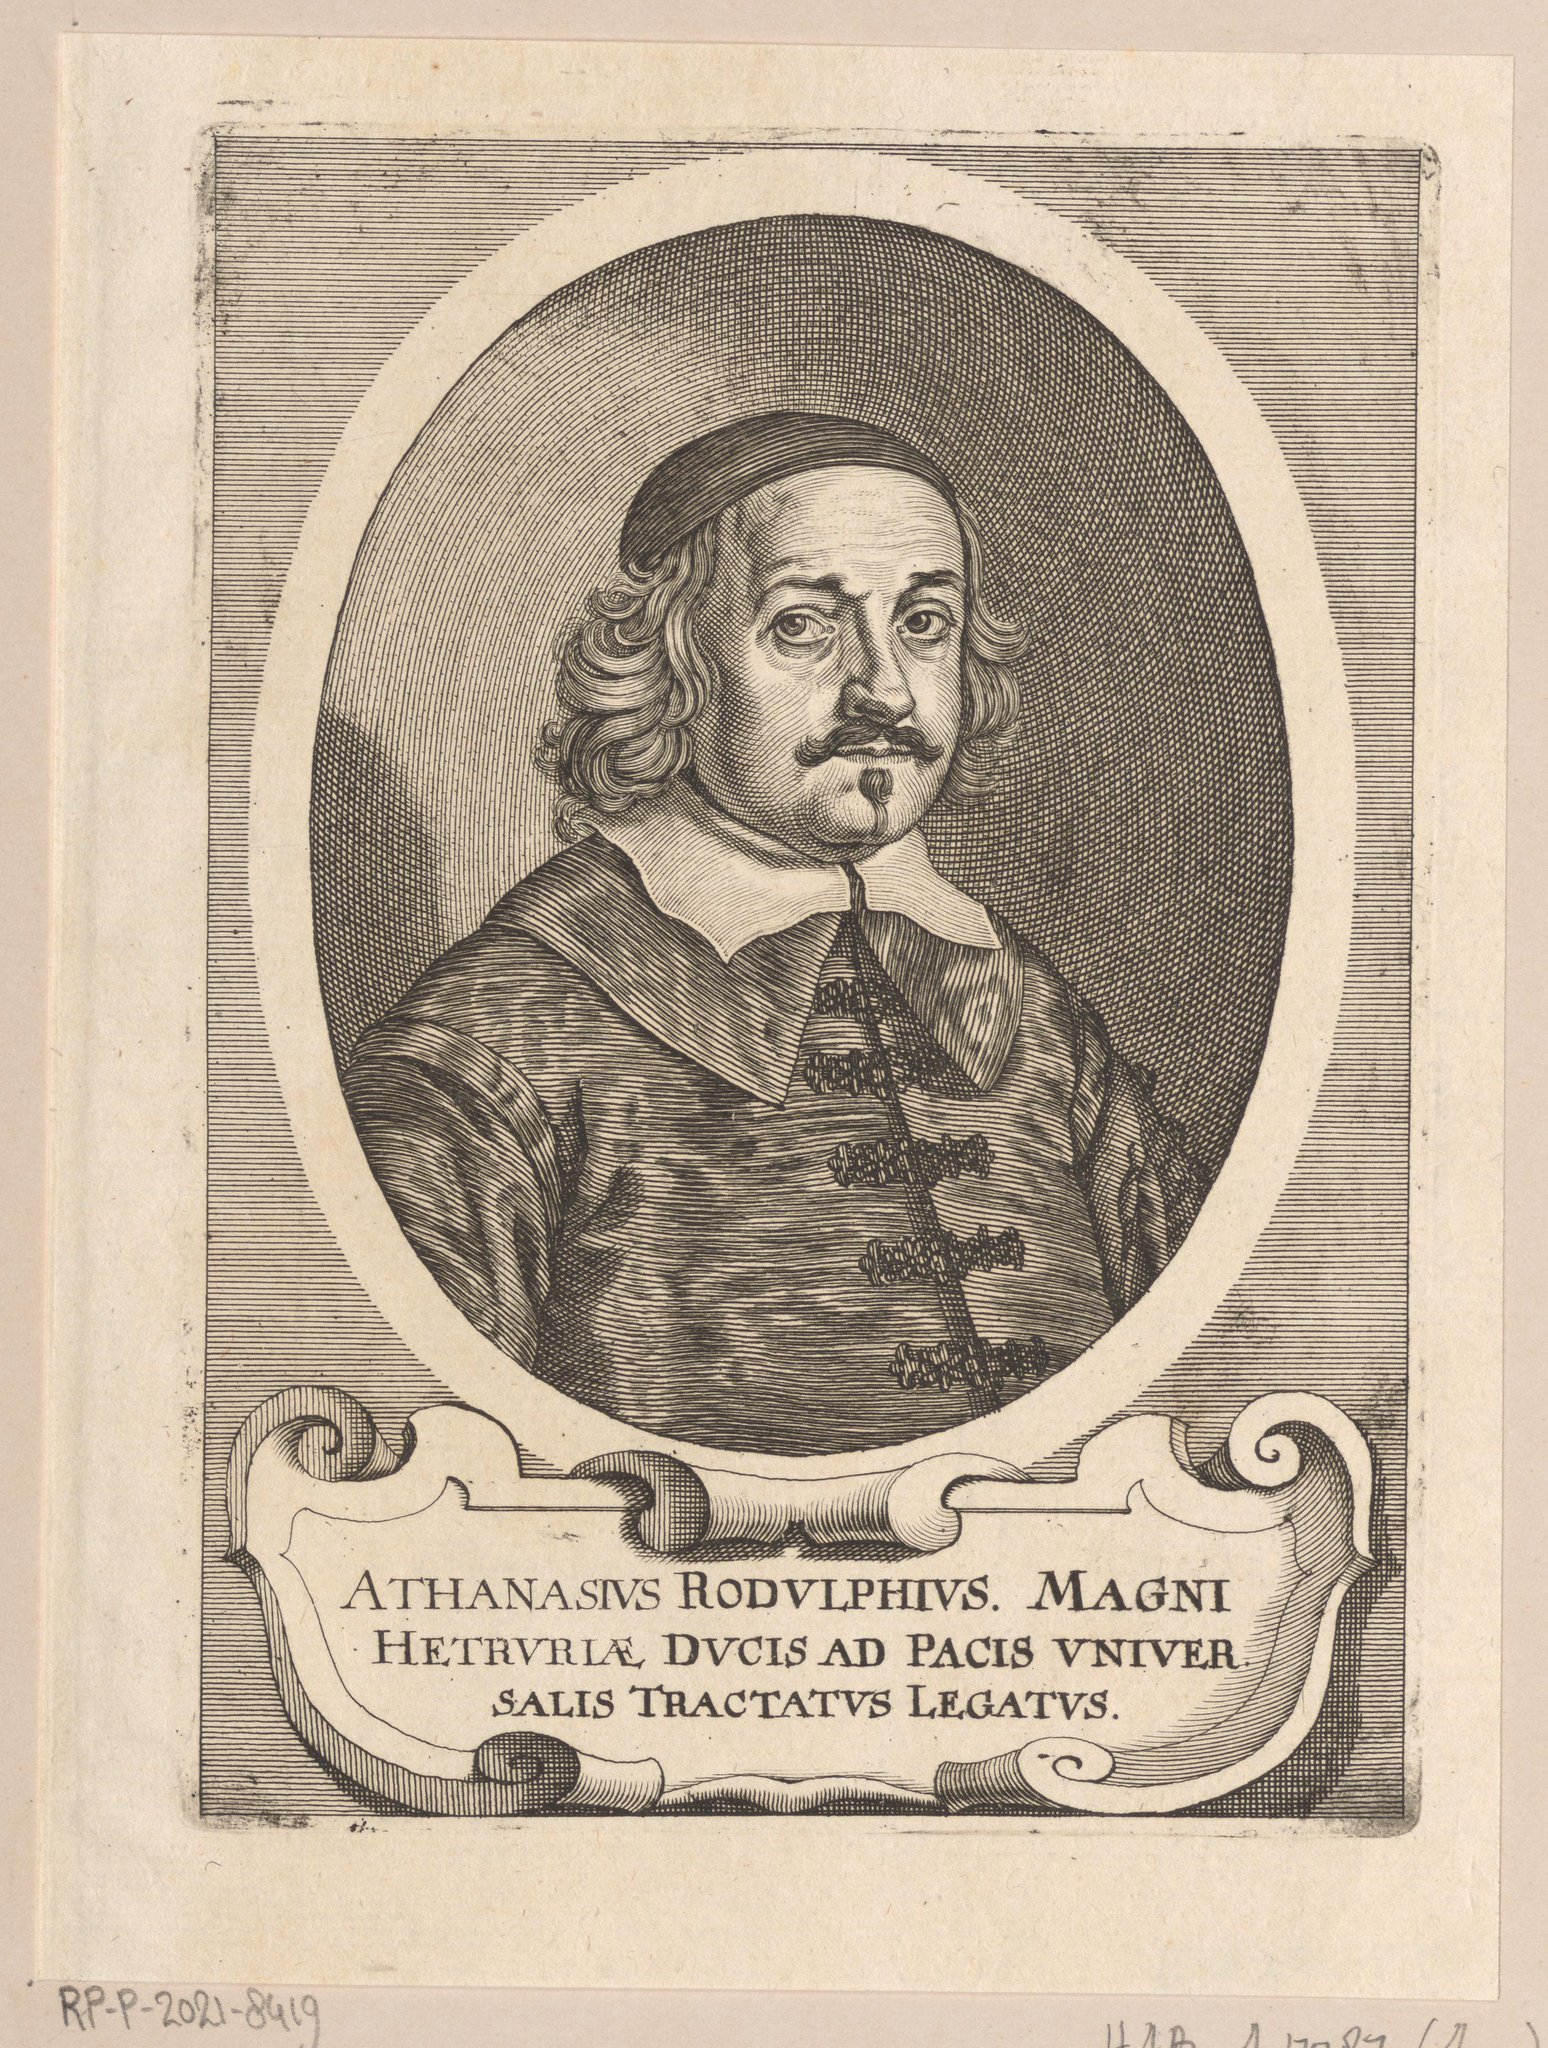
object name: print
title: Portret van Atanasio Rodulfi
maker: Anonymous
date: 1652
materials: paper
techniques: engraving, etching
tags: historical persons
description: Prent mogelijk uit: Theatrum Europaeum (...). Frankfurt am Main: erven Matthaüs Merian, 1652, dl. 6.